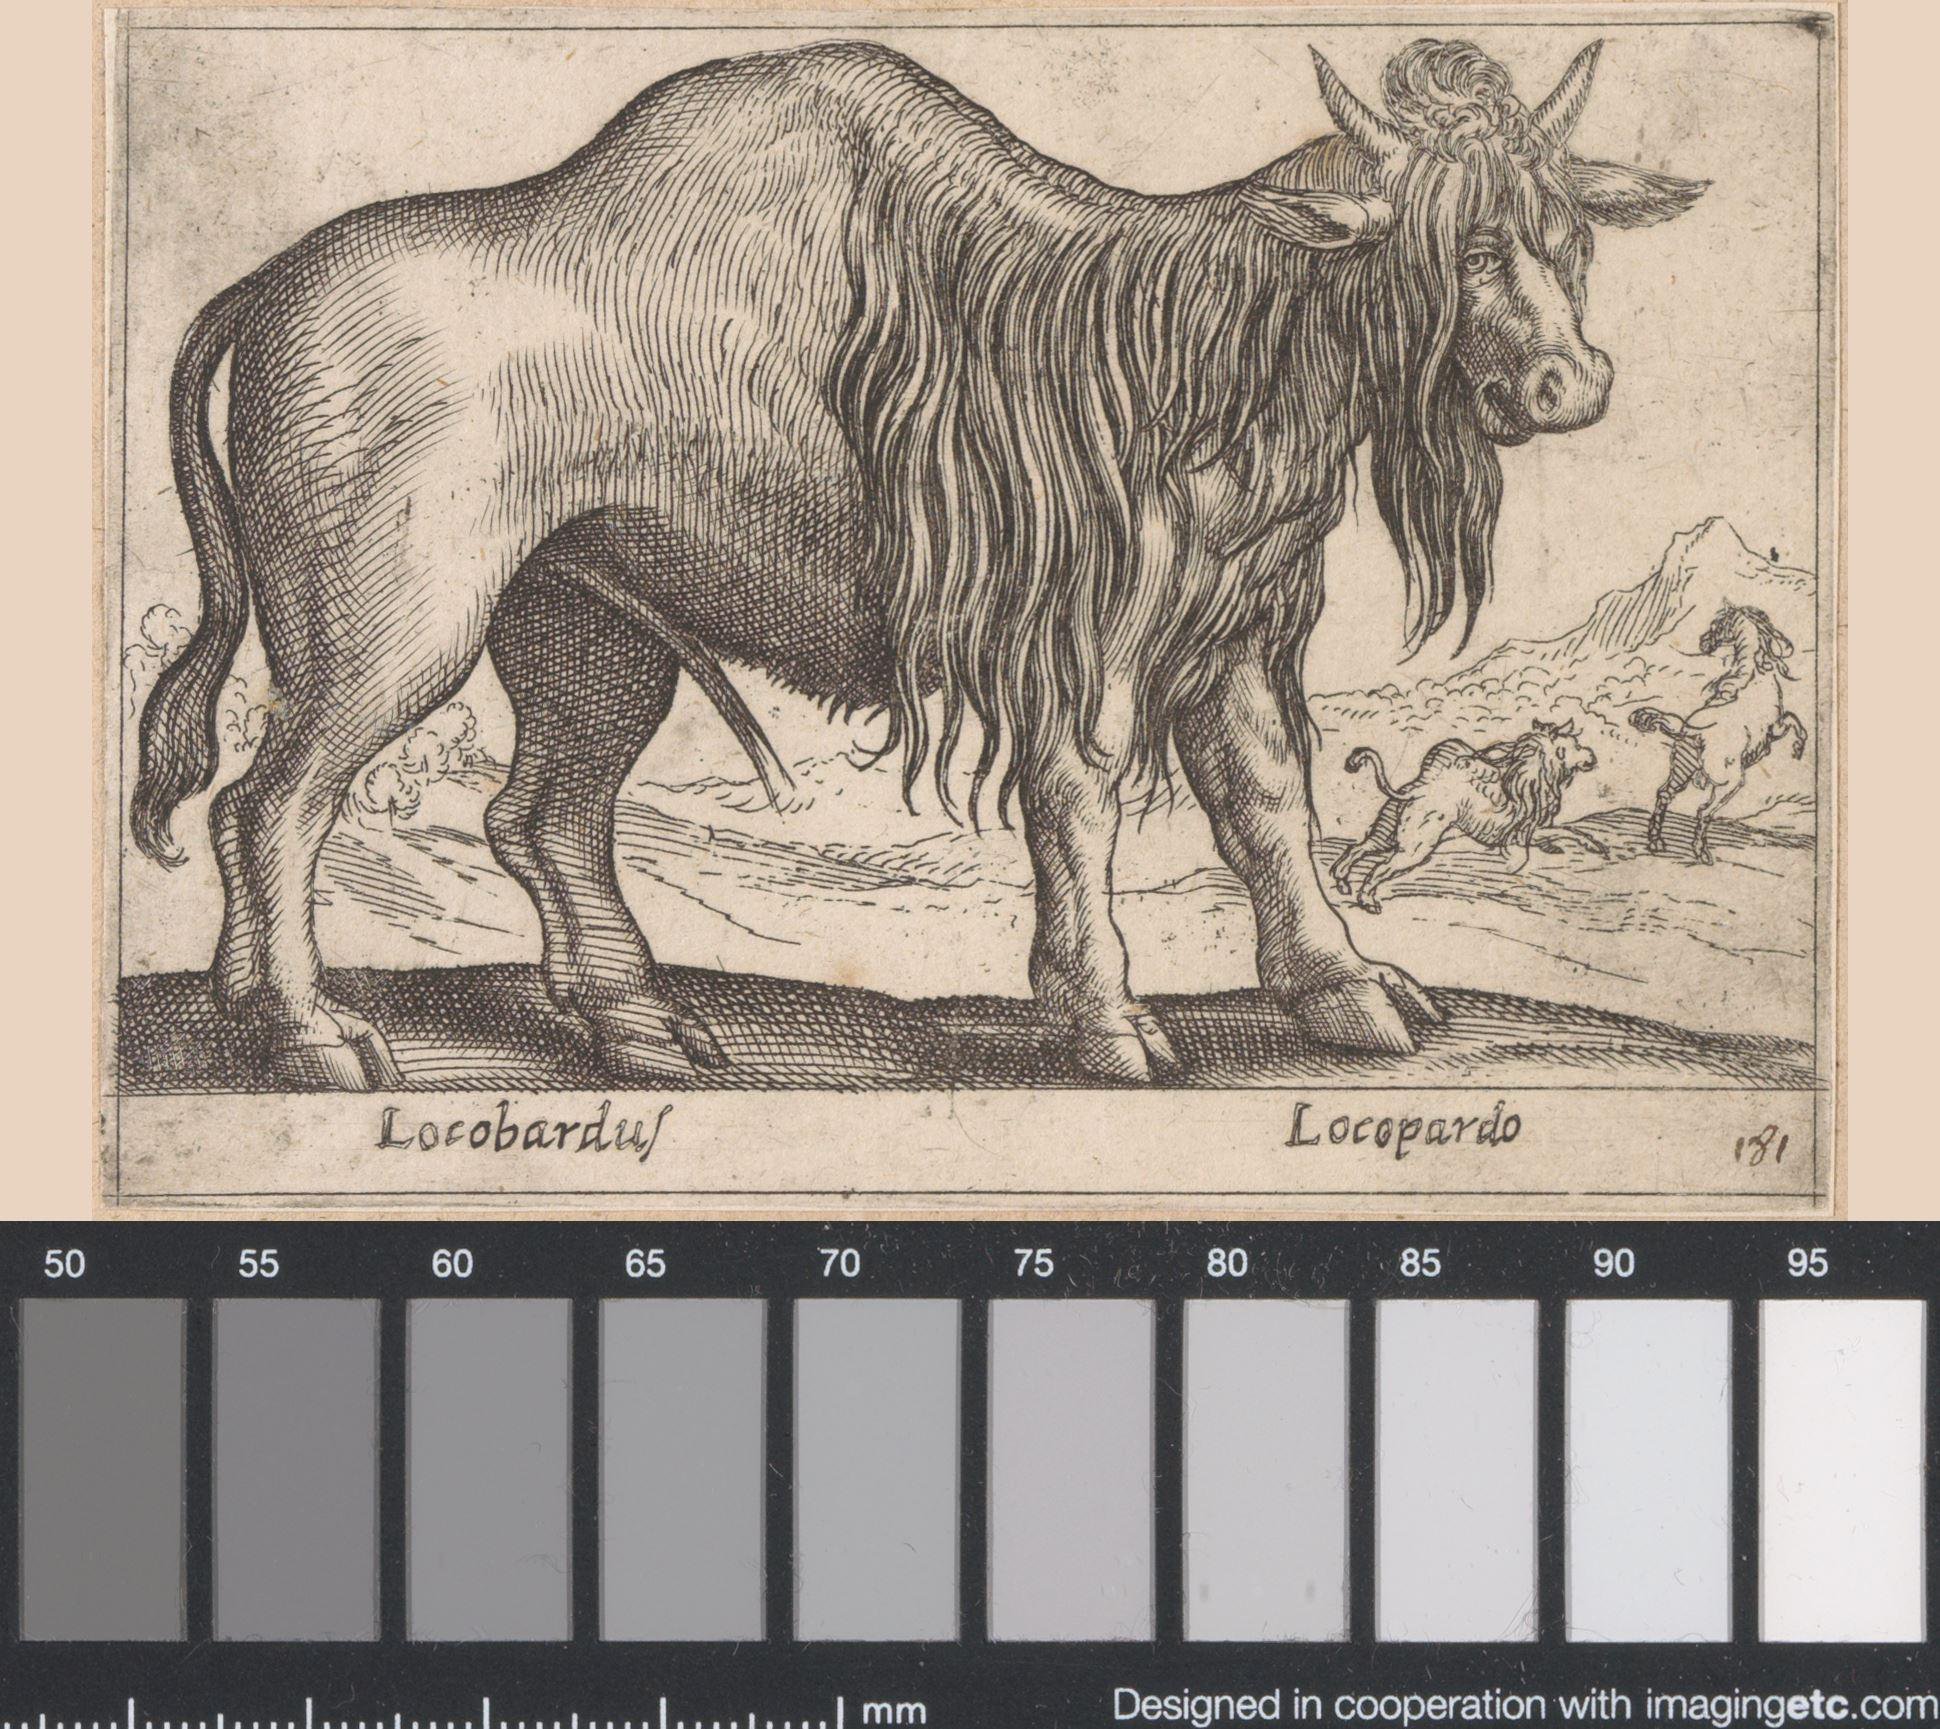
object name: print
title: Rund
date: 1565-1630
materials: paper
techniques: etching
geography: rome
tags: ox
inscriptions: number: ‘129’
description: Deze prent maakt deel uit van een reeks prenten van dieren door Antonio Tempesta. Bekend is dat een tweede staat (met nummering) van deze serie is uitgegeven door Giovanni Giacomo de' Rossi in 1650. Onbekend is wie de eerste staat heeft uitgegeven en wanneer.